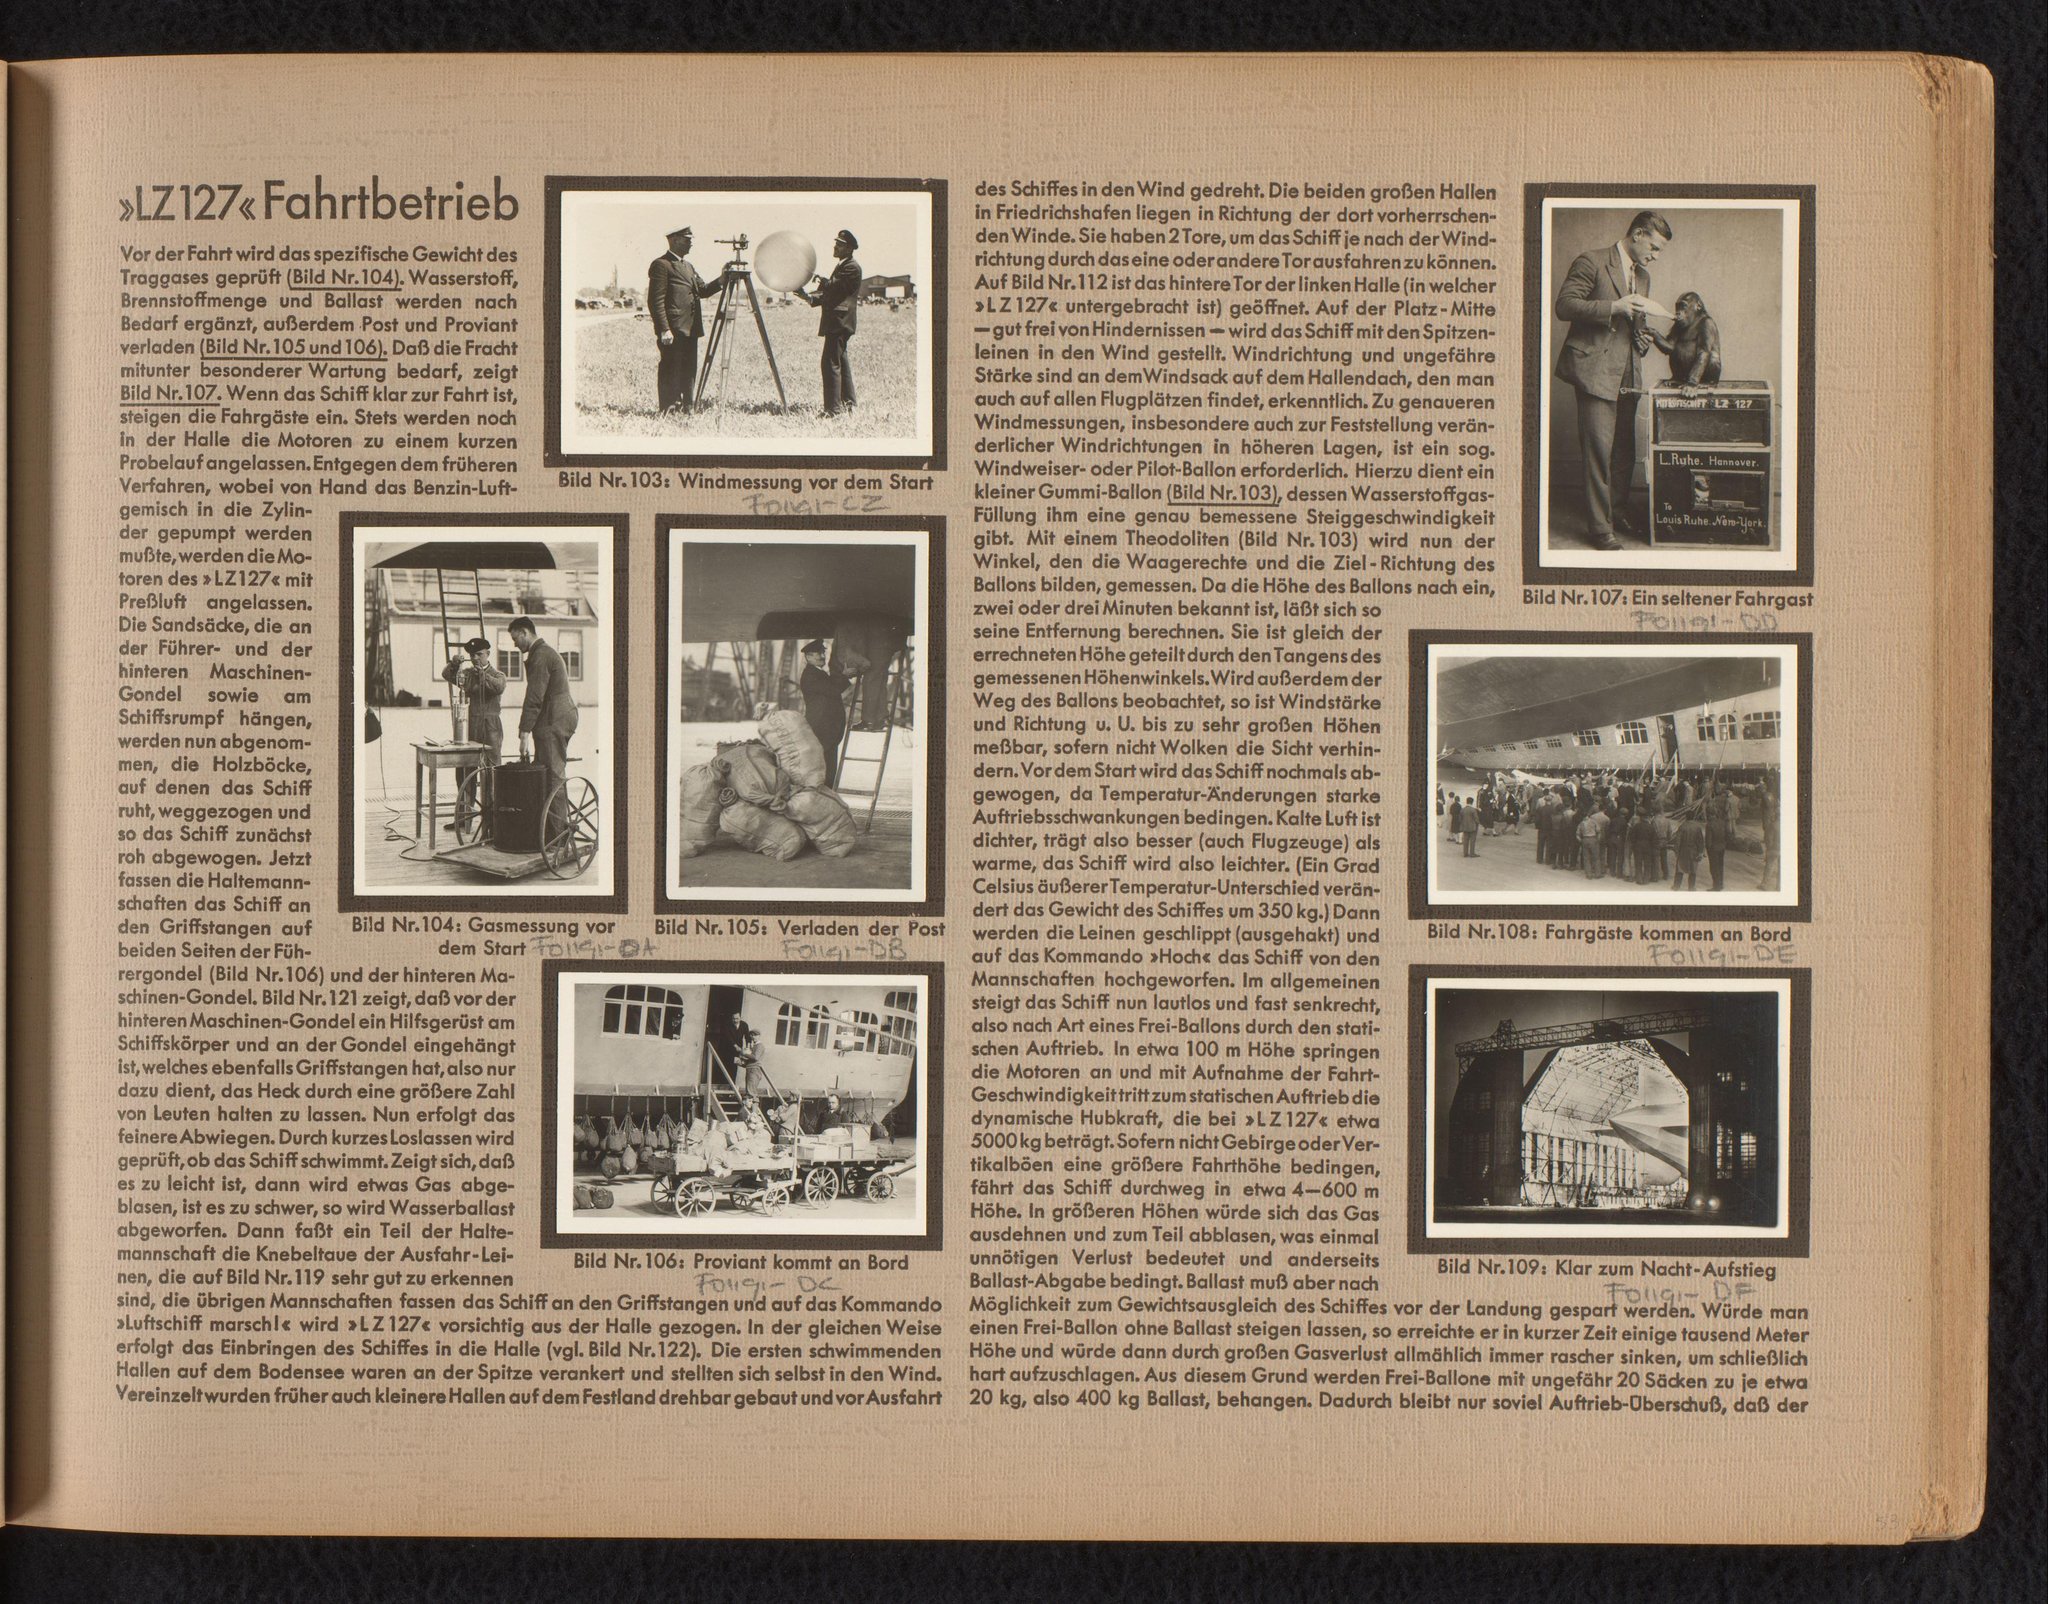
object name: album leaf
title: Voorbereidingen op een vlucht van LZ127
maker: Anonymous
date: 1928-1938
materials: paper, photographic support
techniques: gelatin silver print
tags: monkeys, apes, 46c35 airship, zeppelin, winds, bed, germany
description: Zeven foto's van de voorbereidingen die getroffen werden voor een vlucht van LZ127 zoals een windmeting en gasmeting, maar ook het inladen van proviand. Alle foto's zijn voorzien van een nummer en titel. Deze pagina maakt deel uit van een album.